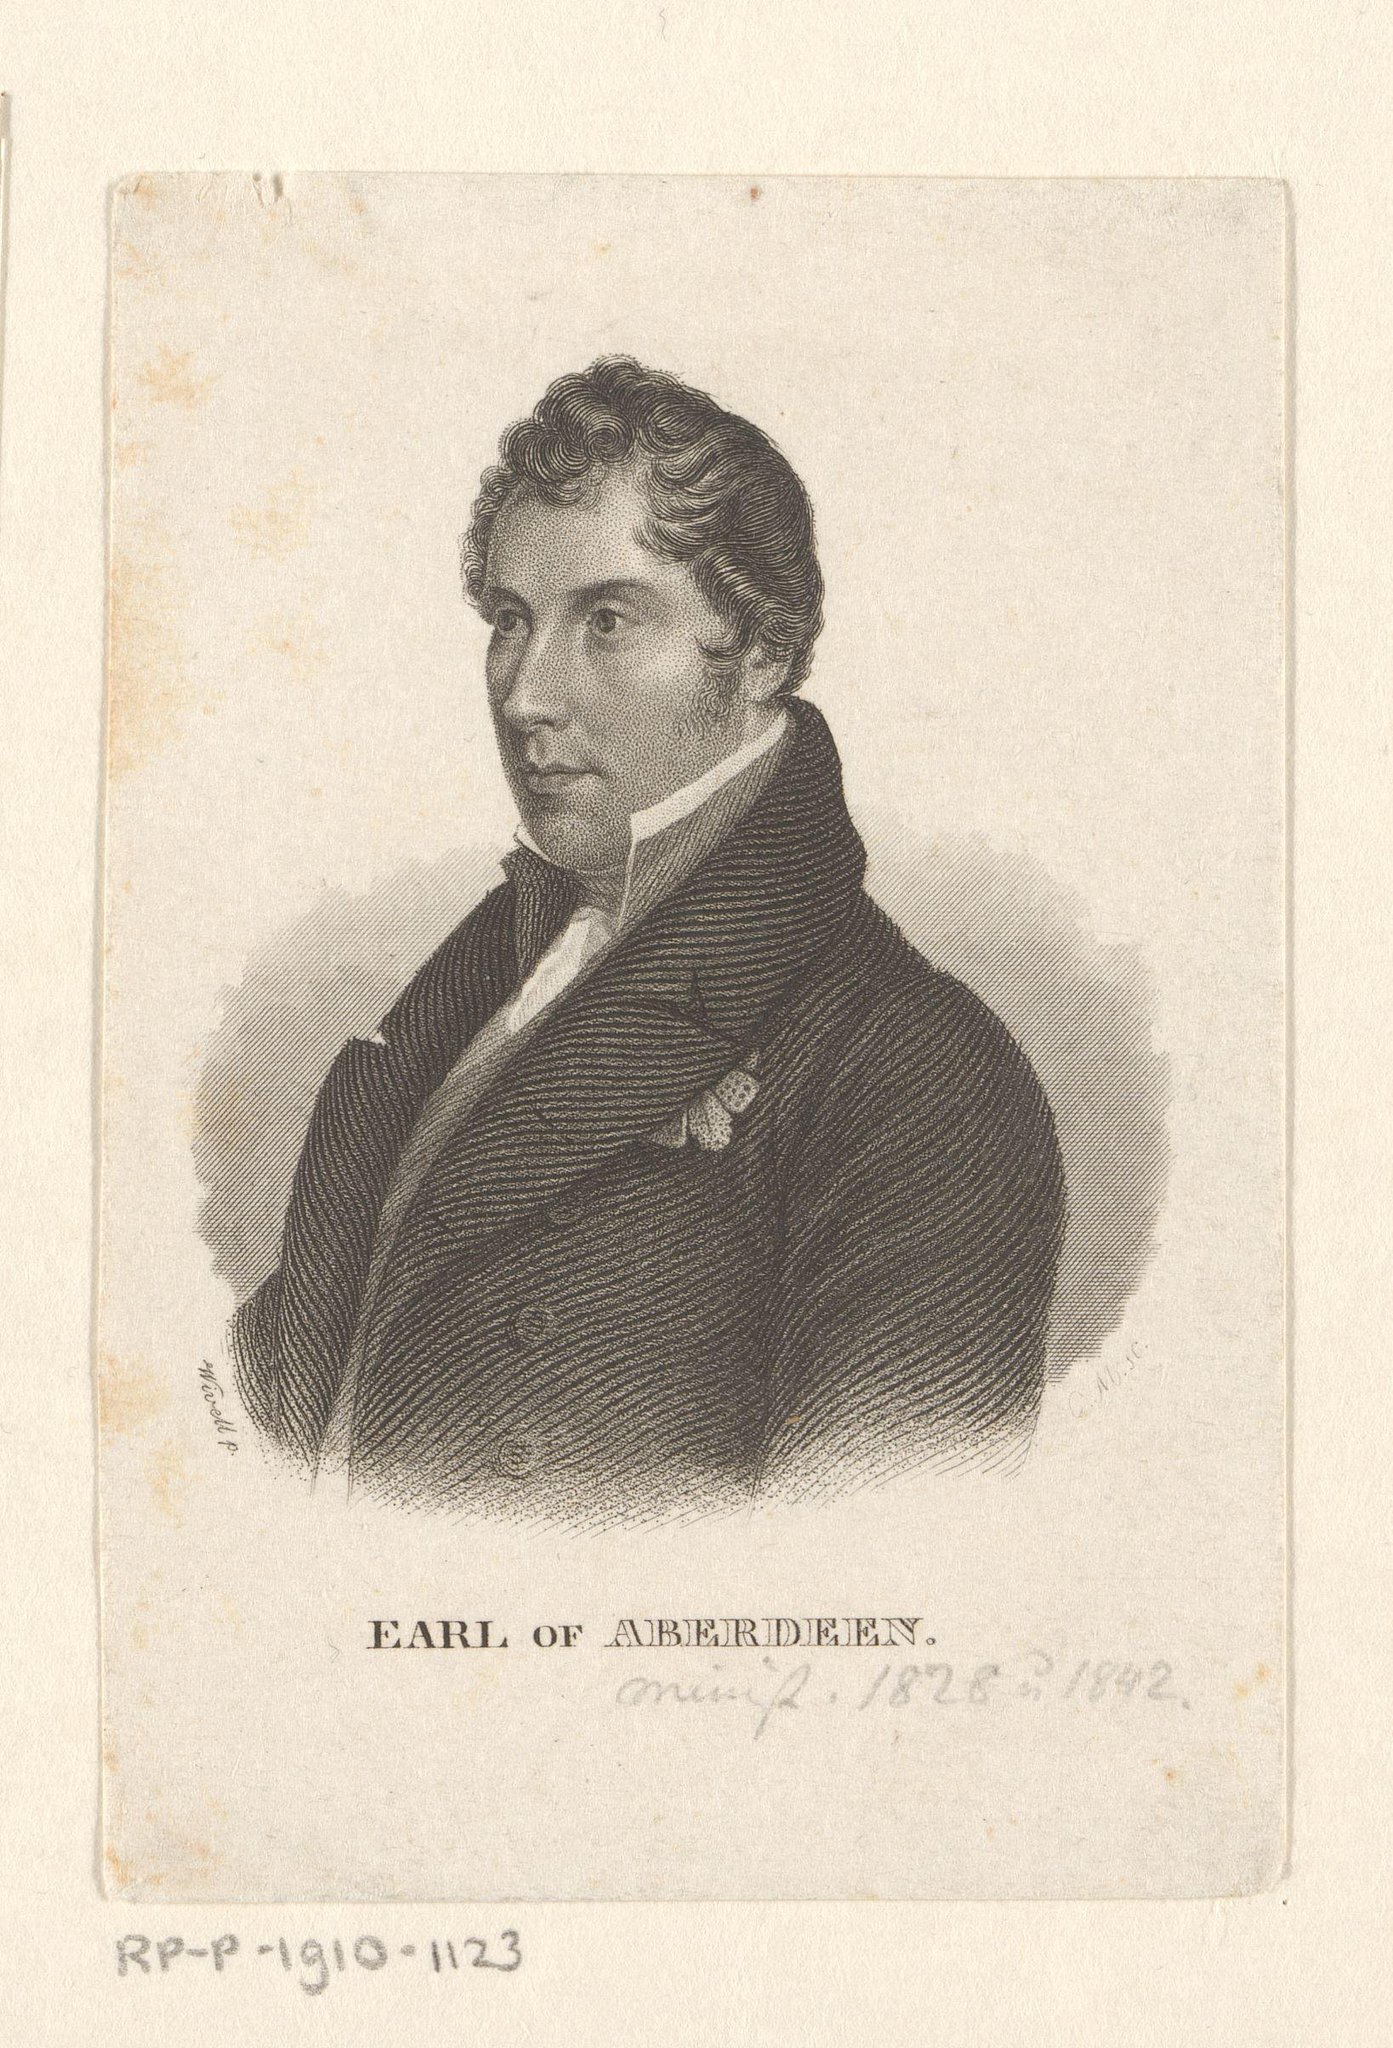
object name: print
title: Portret van George Hamilton-Gordon, graaf van Aberdeen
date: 1845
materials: paper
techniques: engraving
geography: nuremberg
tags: london, politician, historical persons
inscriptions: collector's mark: Lugt 2228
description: Prent afkomstig uit de Almanach de Gotha, 1845.